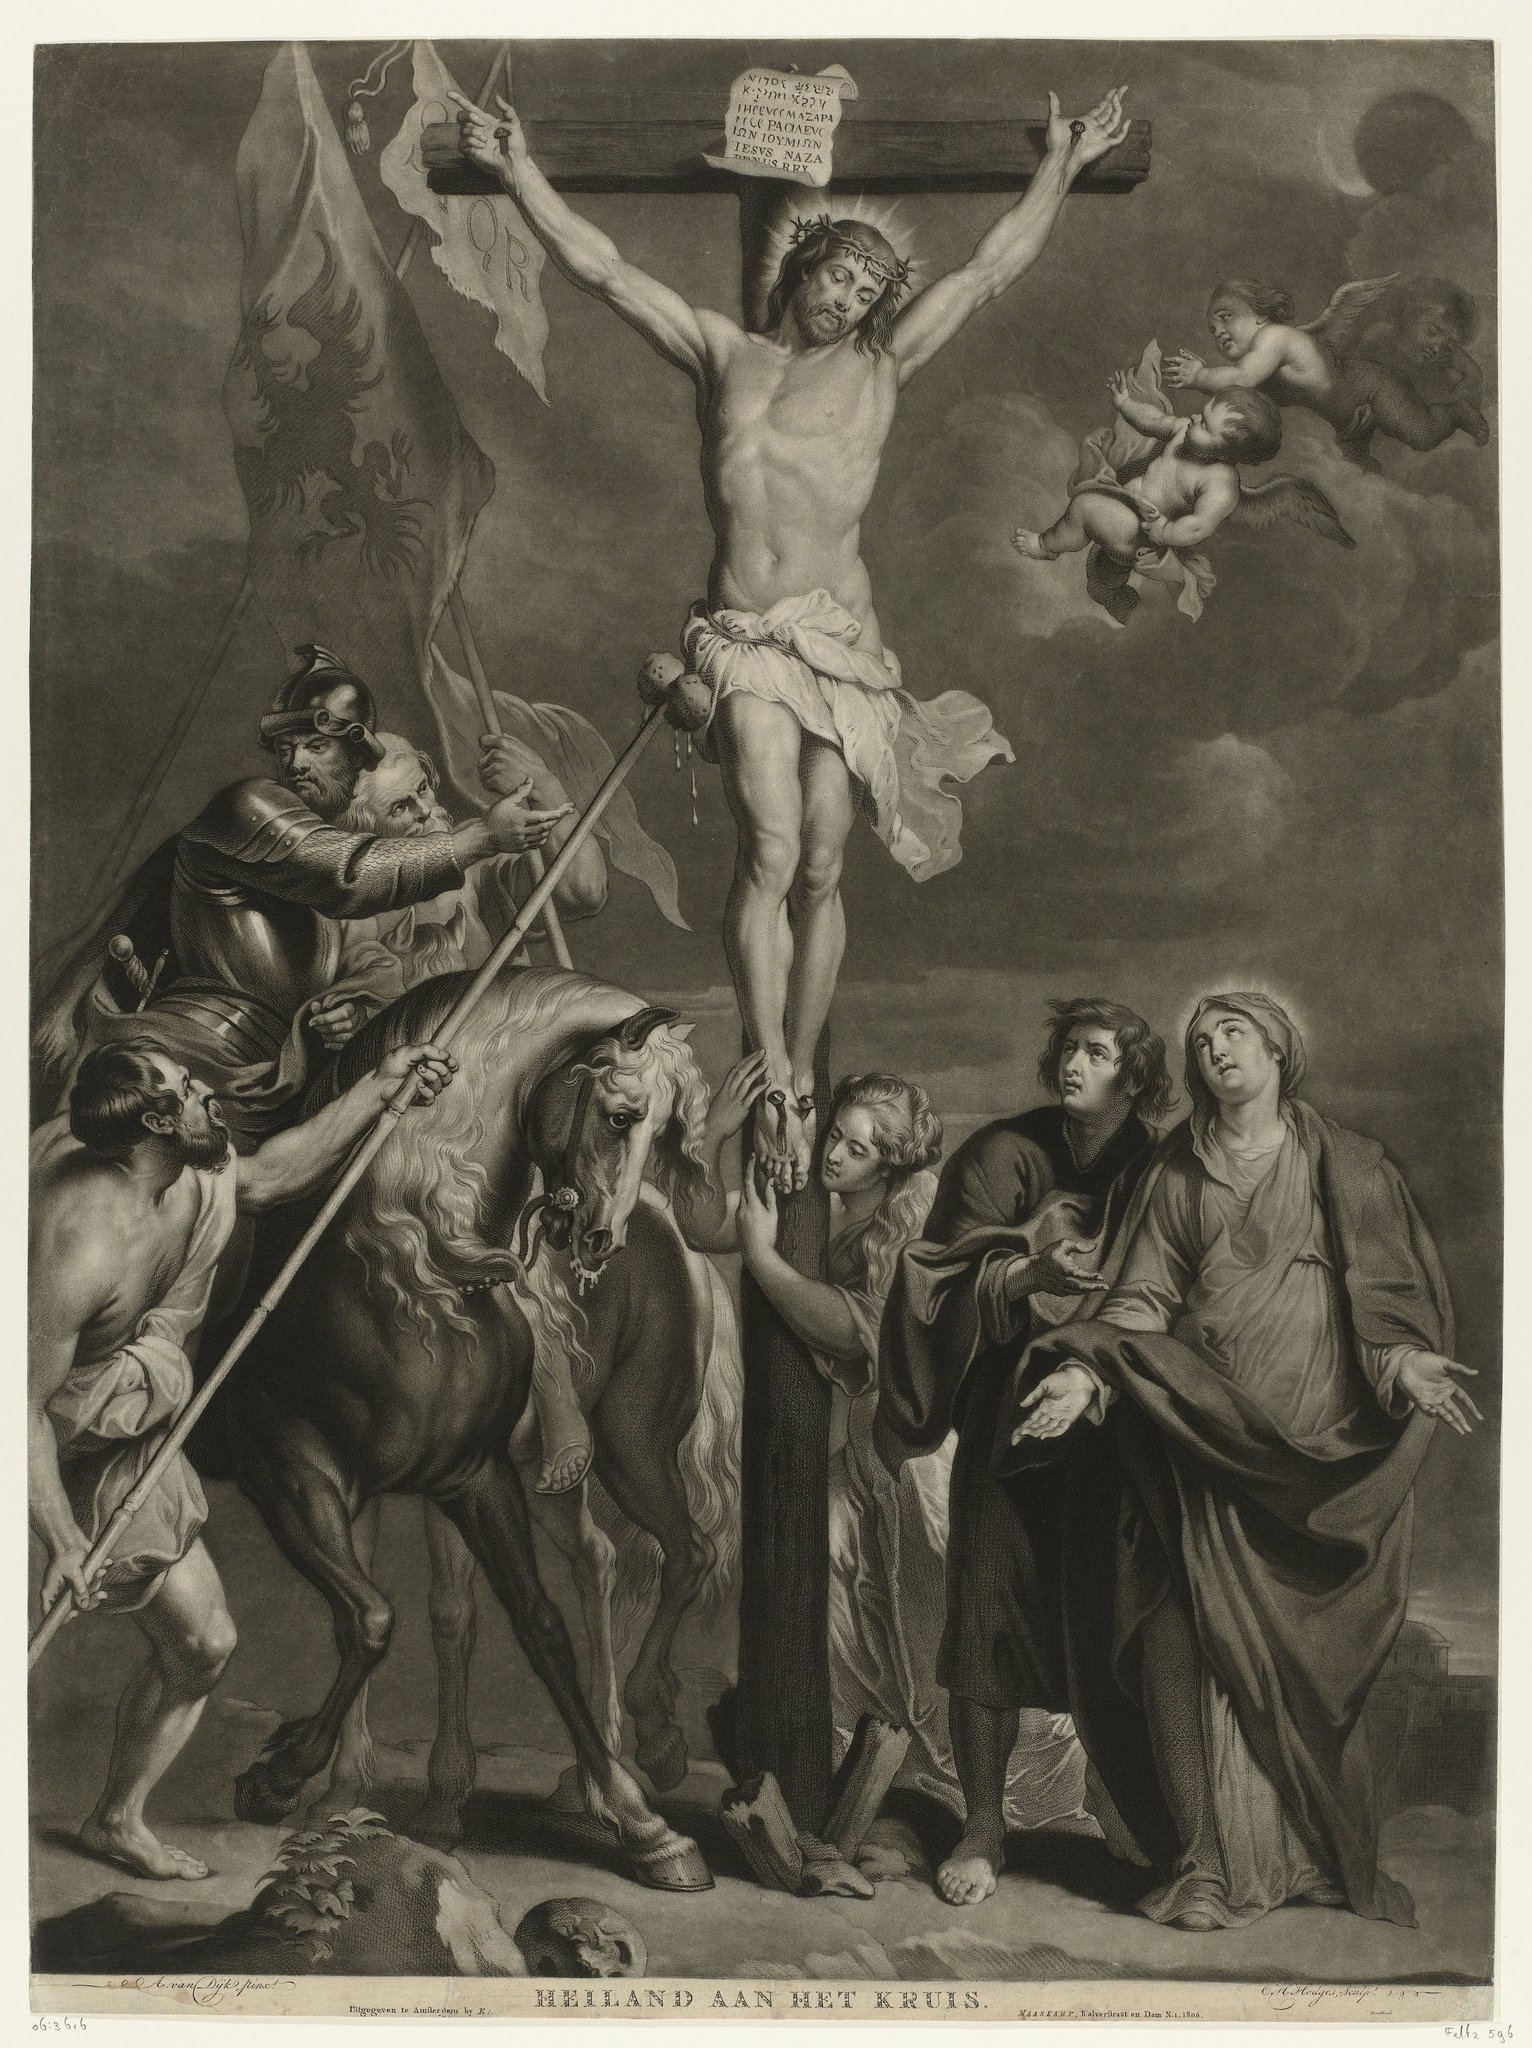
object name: print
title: Heiland aan het kruis.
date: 1806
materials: paper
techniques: etching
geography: amsterdam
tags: crucified christ with mary, john, and mary magdalene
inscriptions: collector's mark: Lugt 2228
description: Christus aan het kruis, met Maria, Johannes, Maria Magdalena en soldaten.